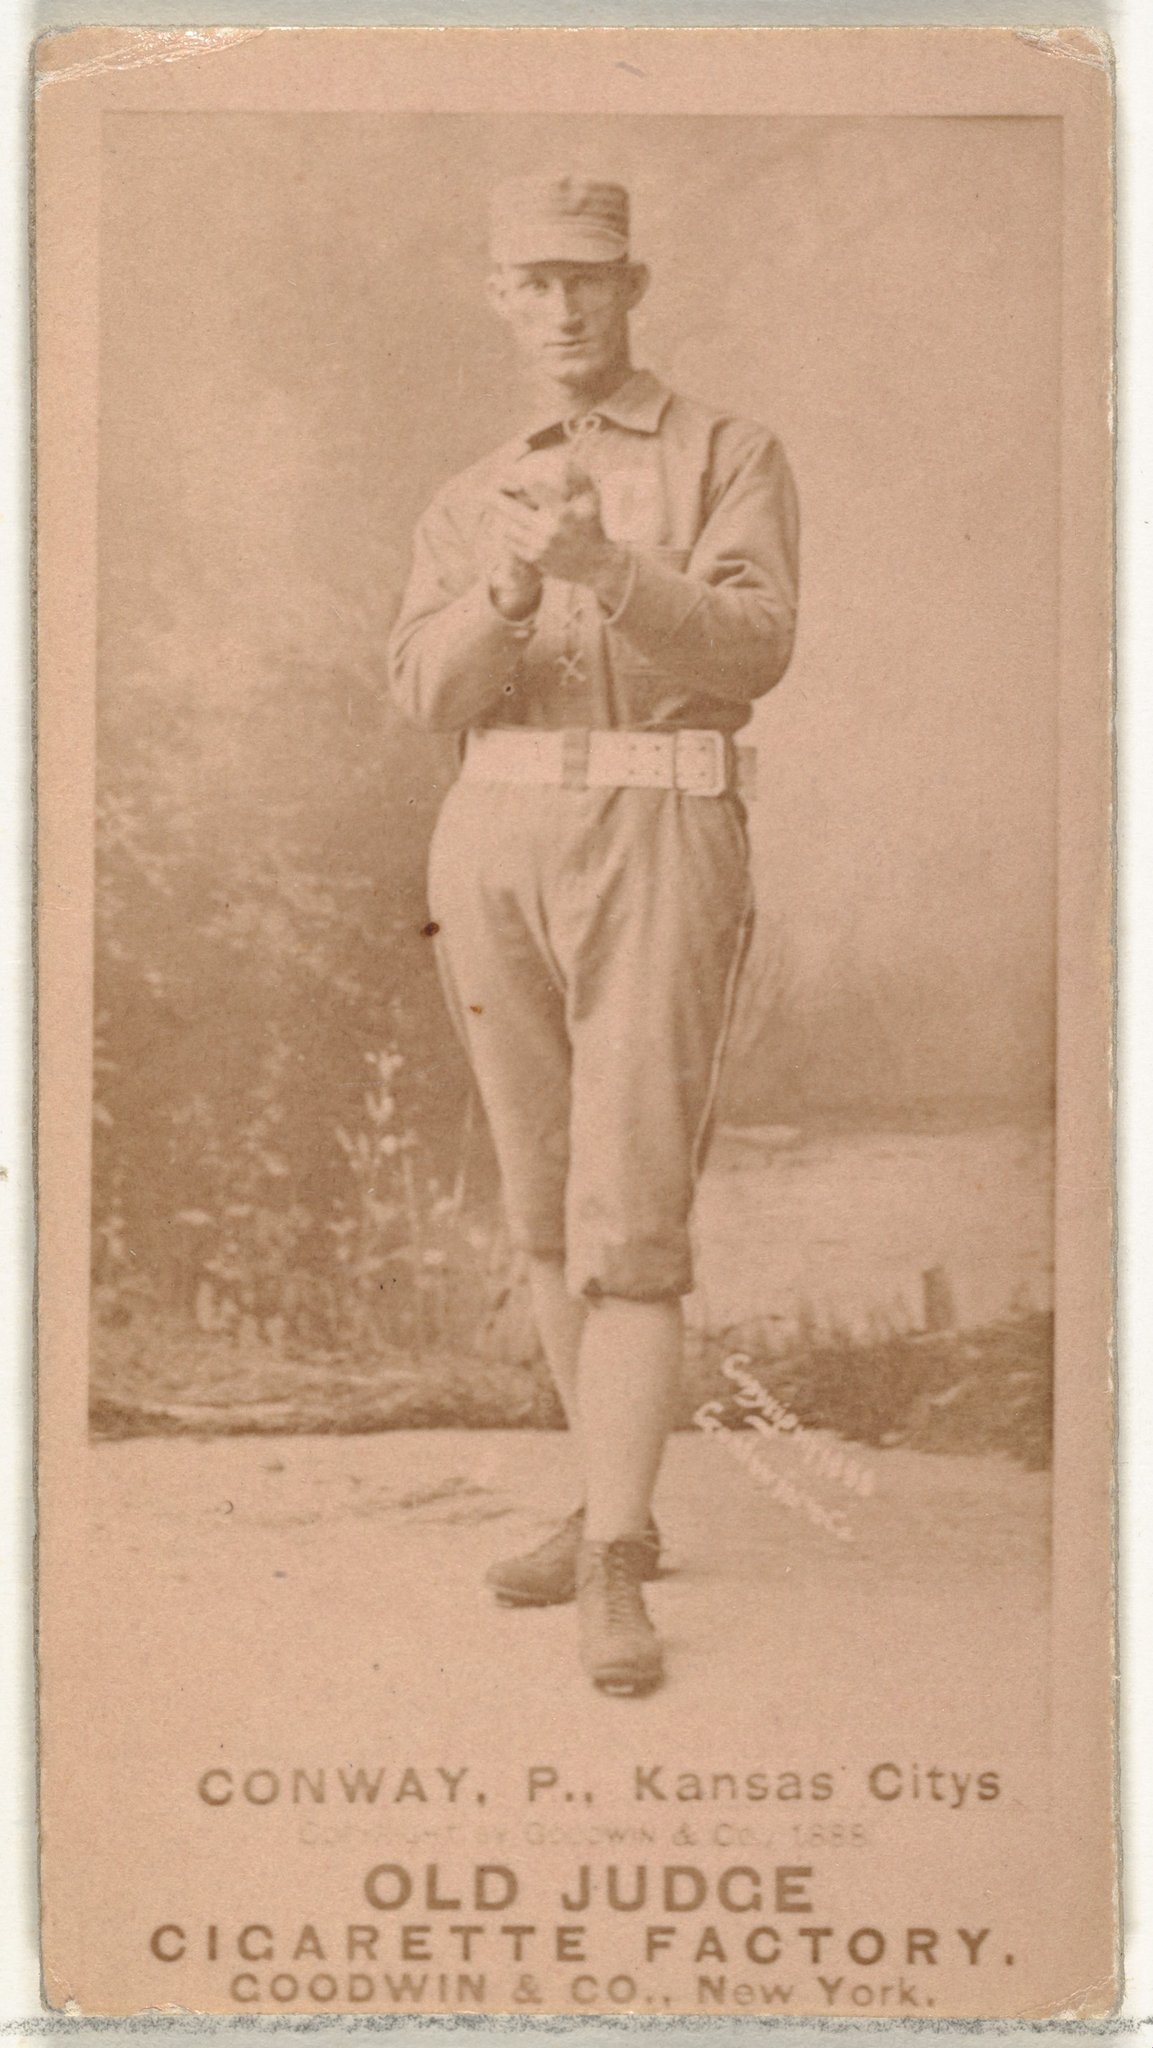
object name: baseball card, photograph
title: James P. "Jim" Conway, Pitcher, Kansas City Cowboys, from the Old Judge series (N172) for Old Judge Cigarettes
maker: goodwin & company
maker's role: publisher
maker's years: 1850-1950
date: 1888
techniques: albumen silver print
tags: men,portraits,baseball,athletes